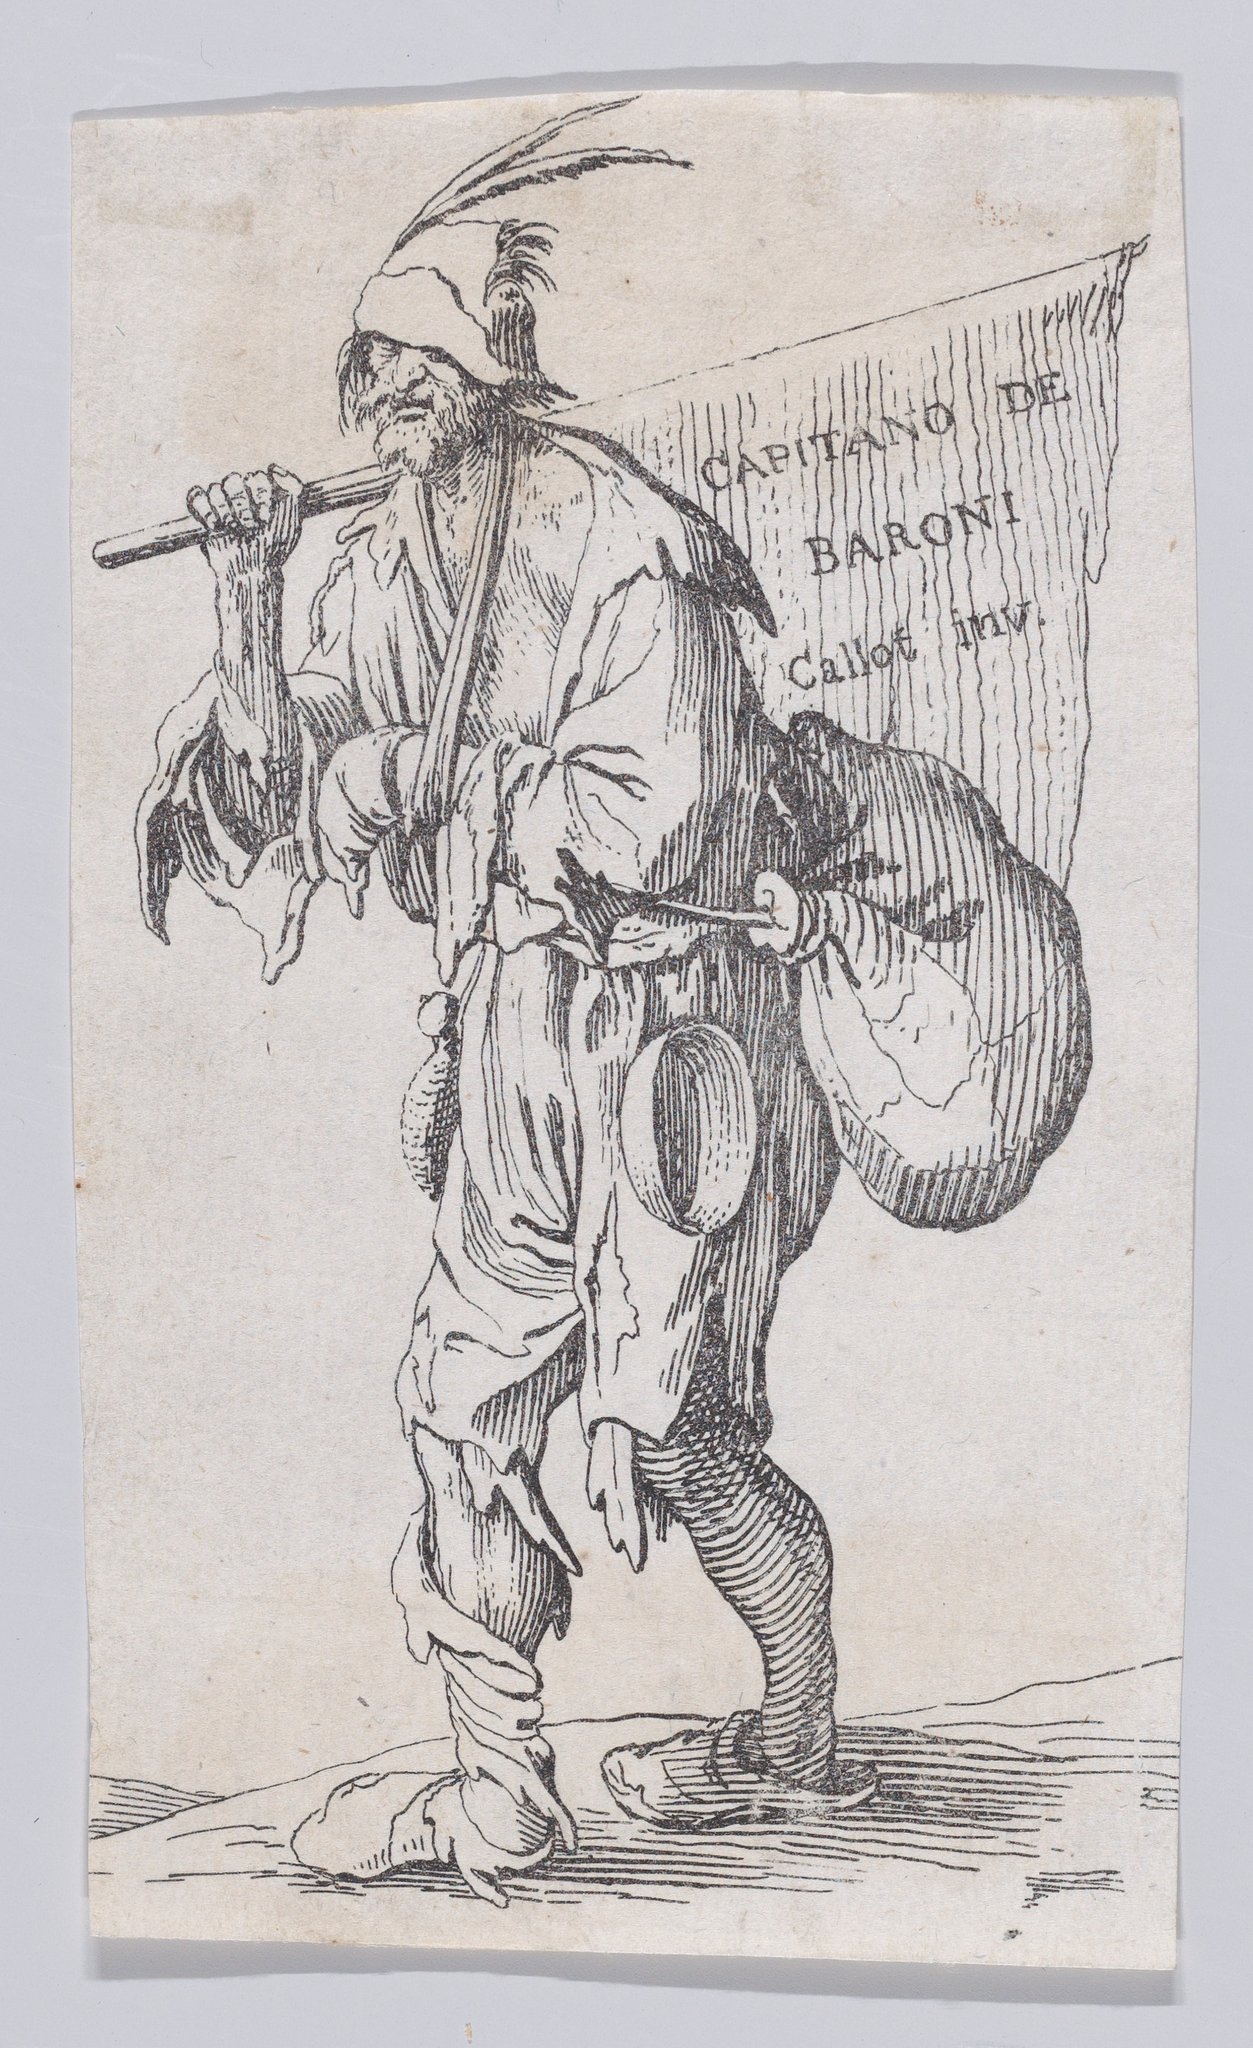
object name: print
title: Reverse Copy of the Frontispiece, from "Les Gueux suite appelée aussi Les Mendiants, Les Baroni, ou Les Barons" (The Beggars, also called the Barons)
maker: Anonymous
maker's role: artist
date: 1601-1700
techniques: etching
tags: men